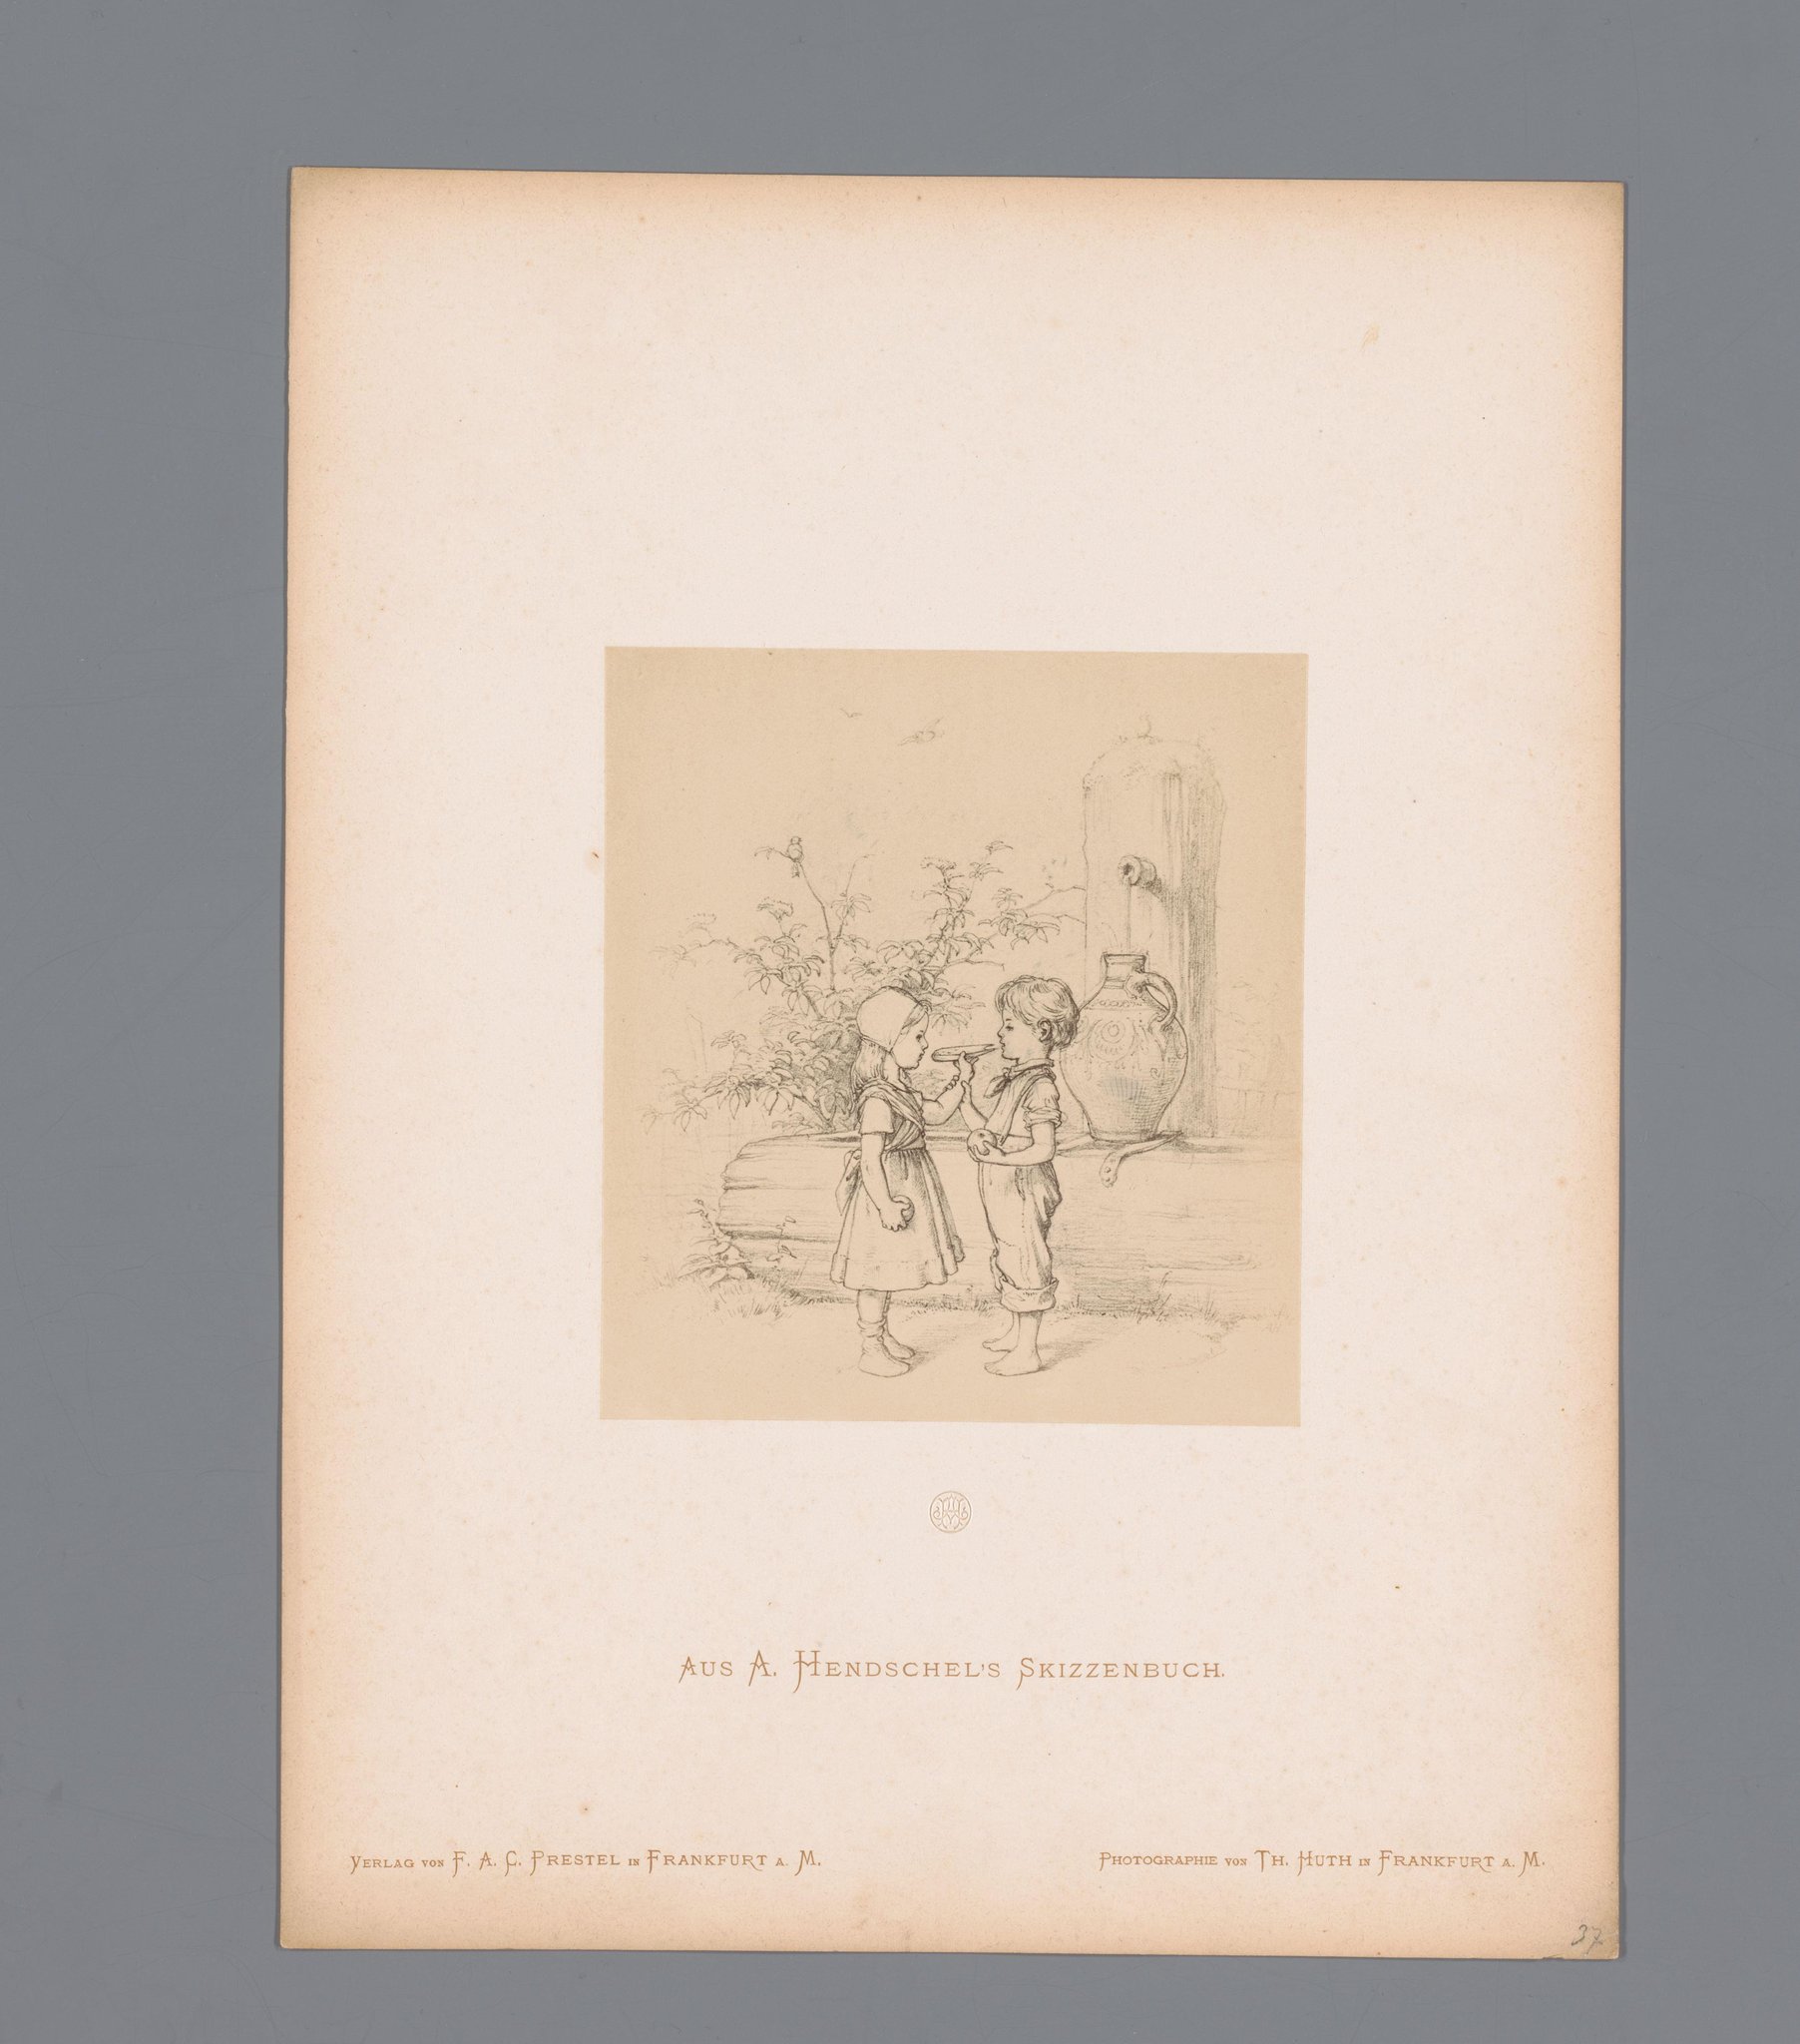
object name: photograph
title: Aus A. Hendschel's Skizzenbuch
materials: photographic support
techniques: albumen print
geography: frankfurt am main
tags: well, child (+ two persons)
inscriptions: number: ‘37’, monogram: ‘AH’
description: Deze foto maakt deel uit van een omslag met 50 foto's op 48 bladen, een lijst van afbeeldingen en een titelblad.